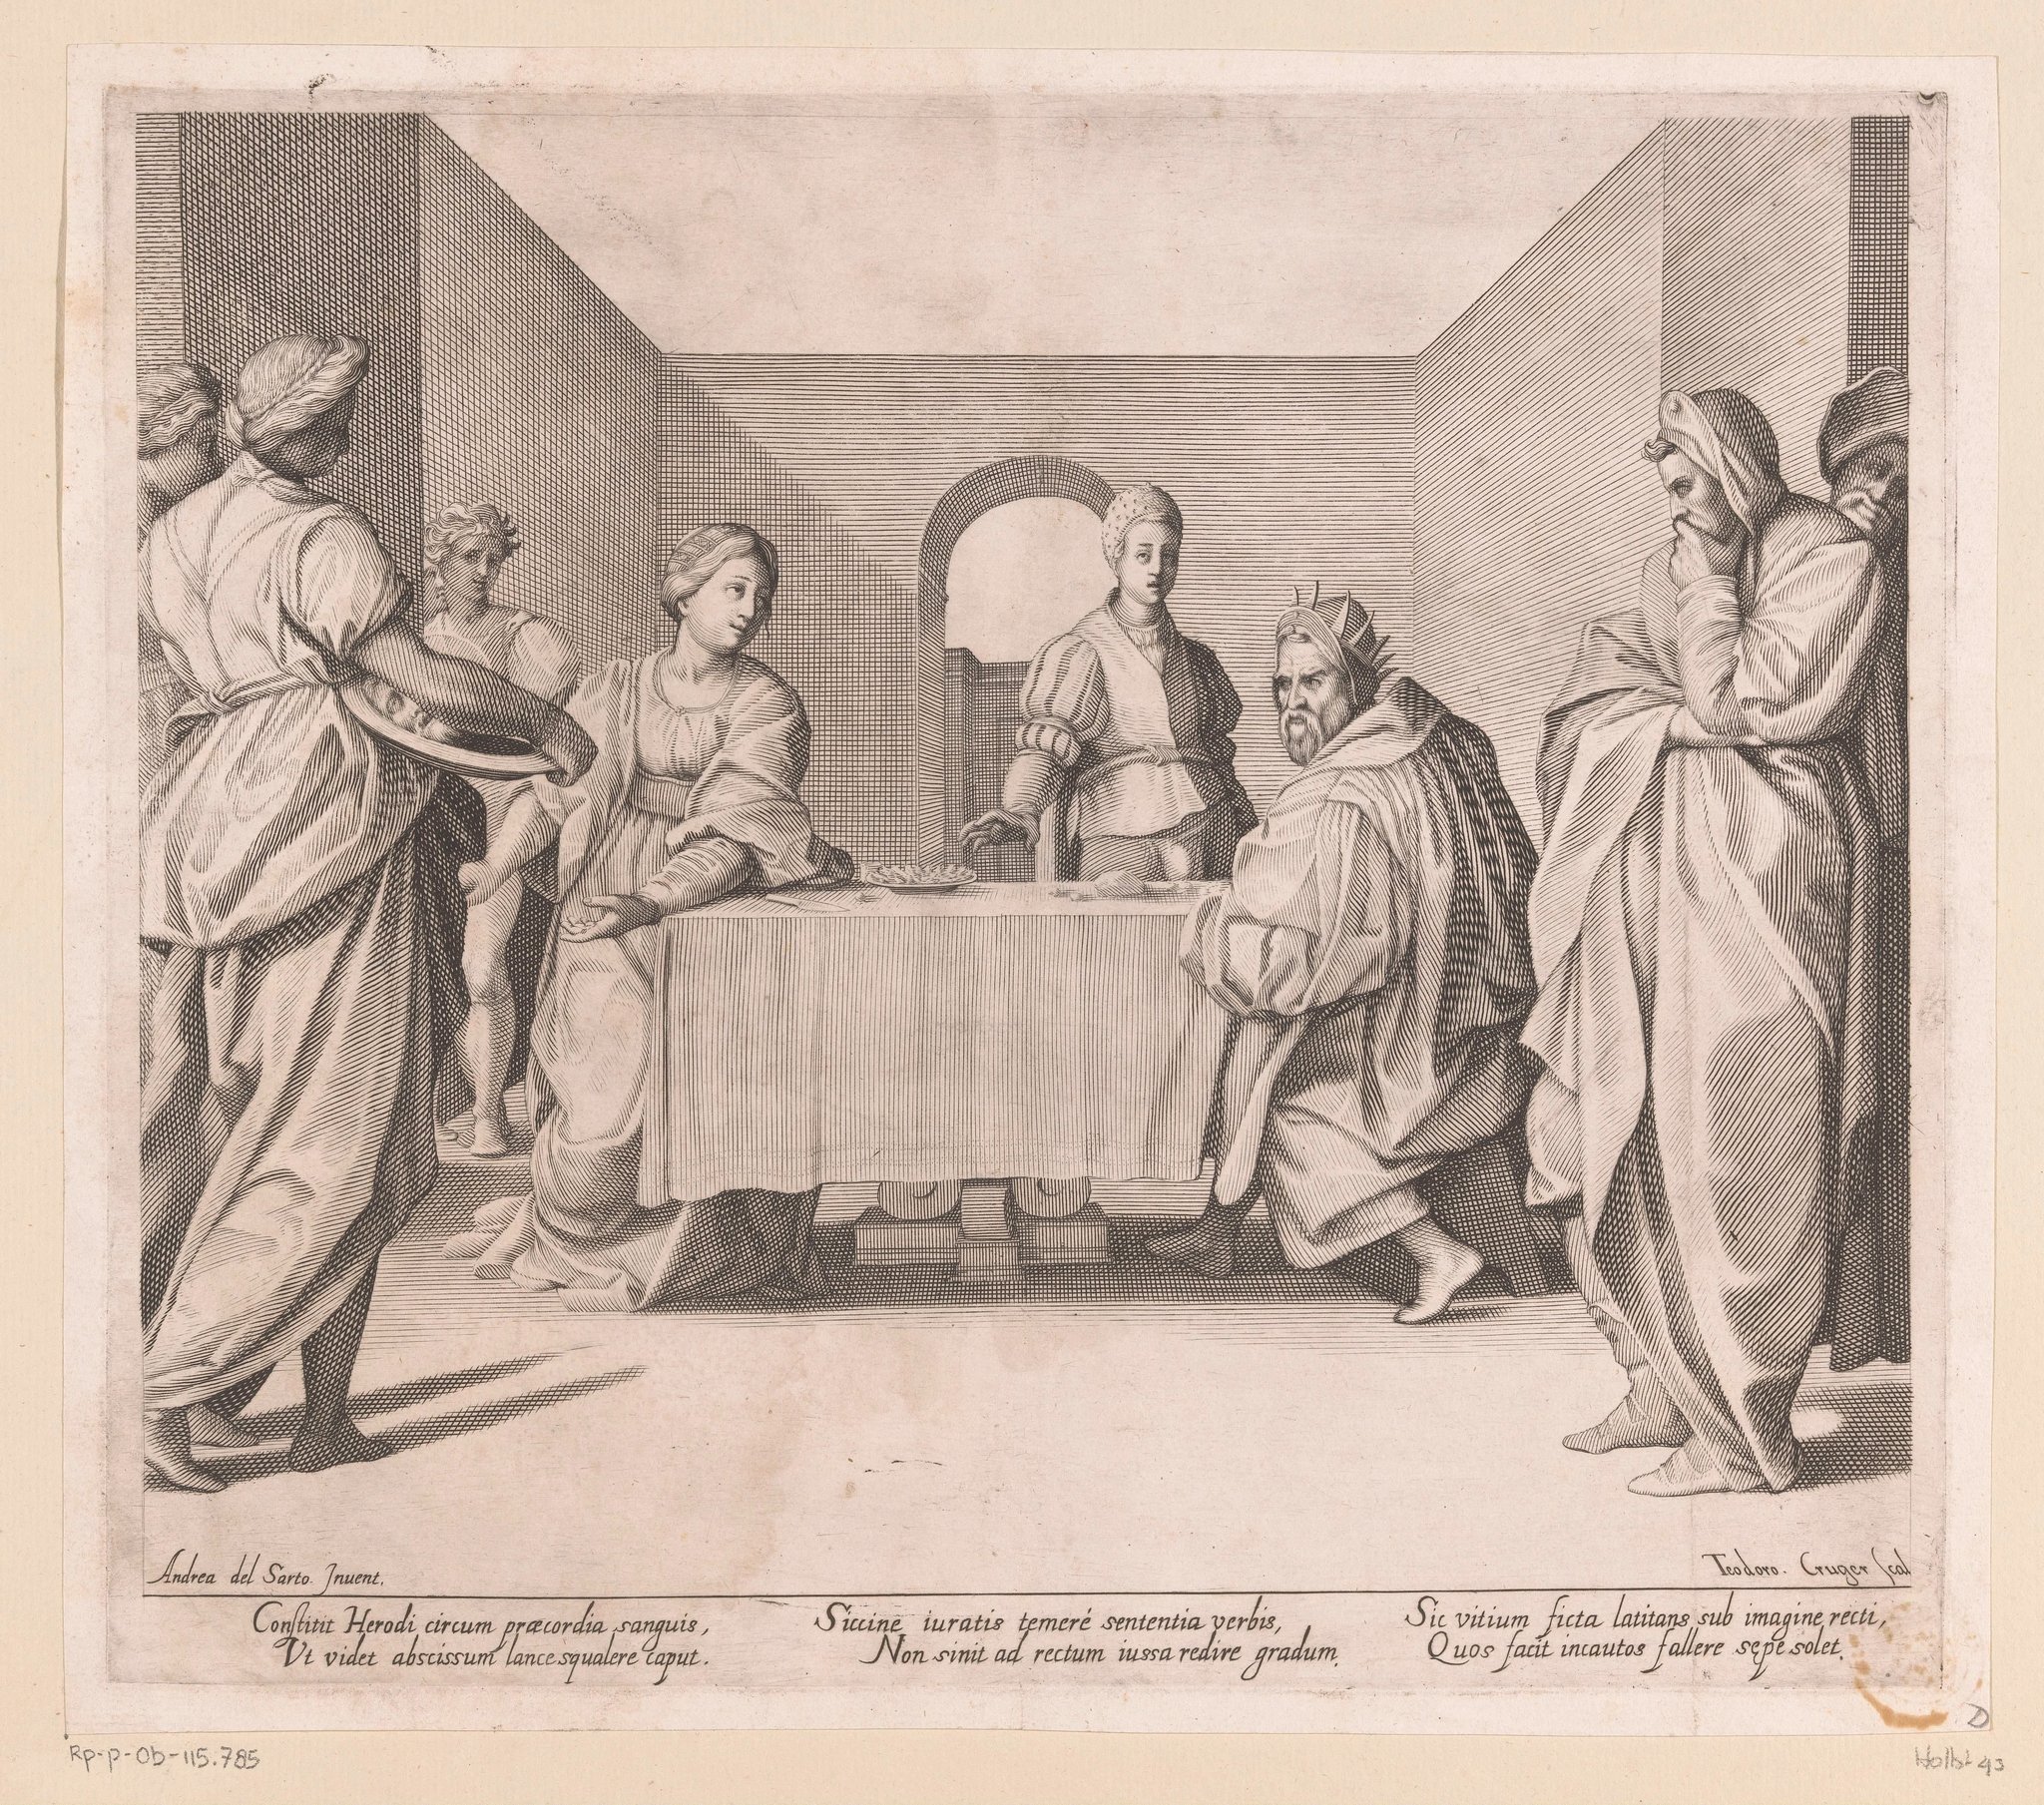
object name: print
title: Salome brengt Herodias het hoofd van Johannes de Doper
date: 1617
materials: paper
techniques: engraving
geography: florence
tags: salome gives the head of john the baptist to her mother, salome with the head of john the baptist on a dish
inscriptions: collector's mark: Lugt 240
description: Onderdeel van een serie van dertien prenten en een titelprent.